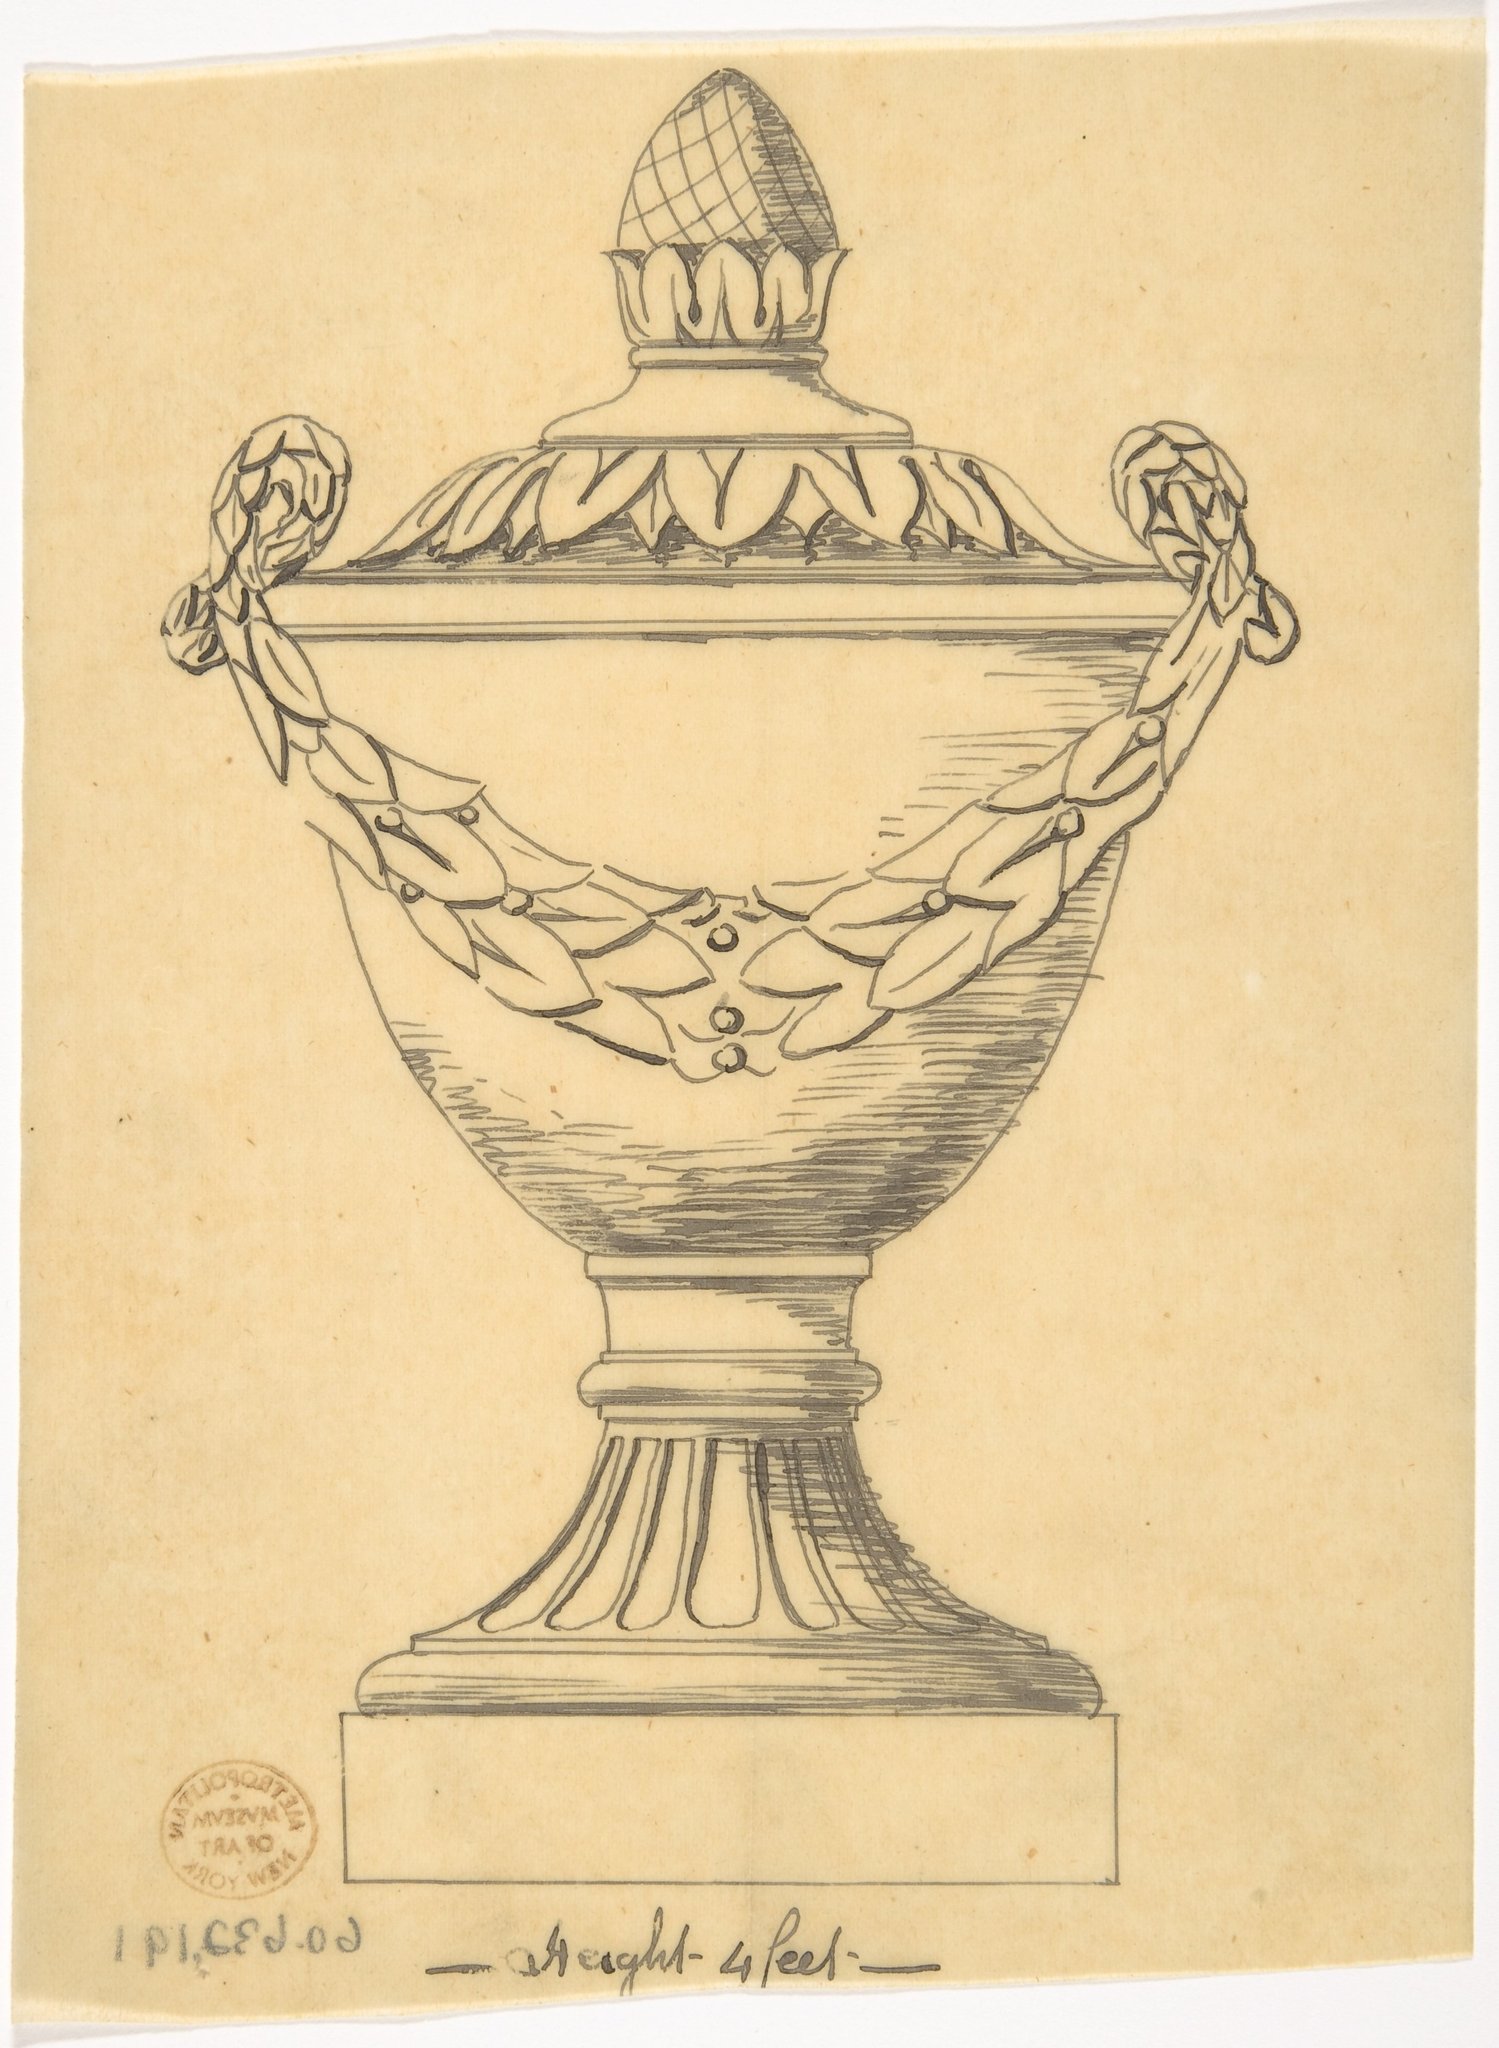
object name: drawing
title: Classical Vase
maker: anonymous, british, 19th century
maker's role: artist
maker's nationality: british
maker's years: 1800-1900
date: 1801-1900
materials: ink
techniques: pen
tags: vases